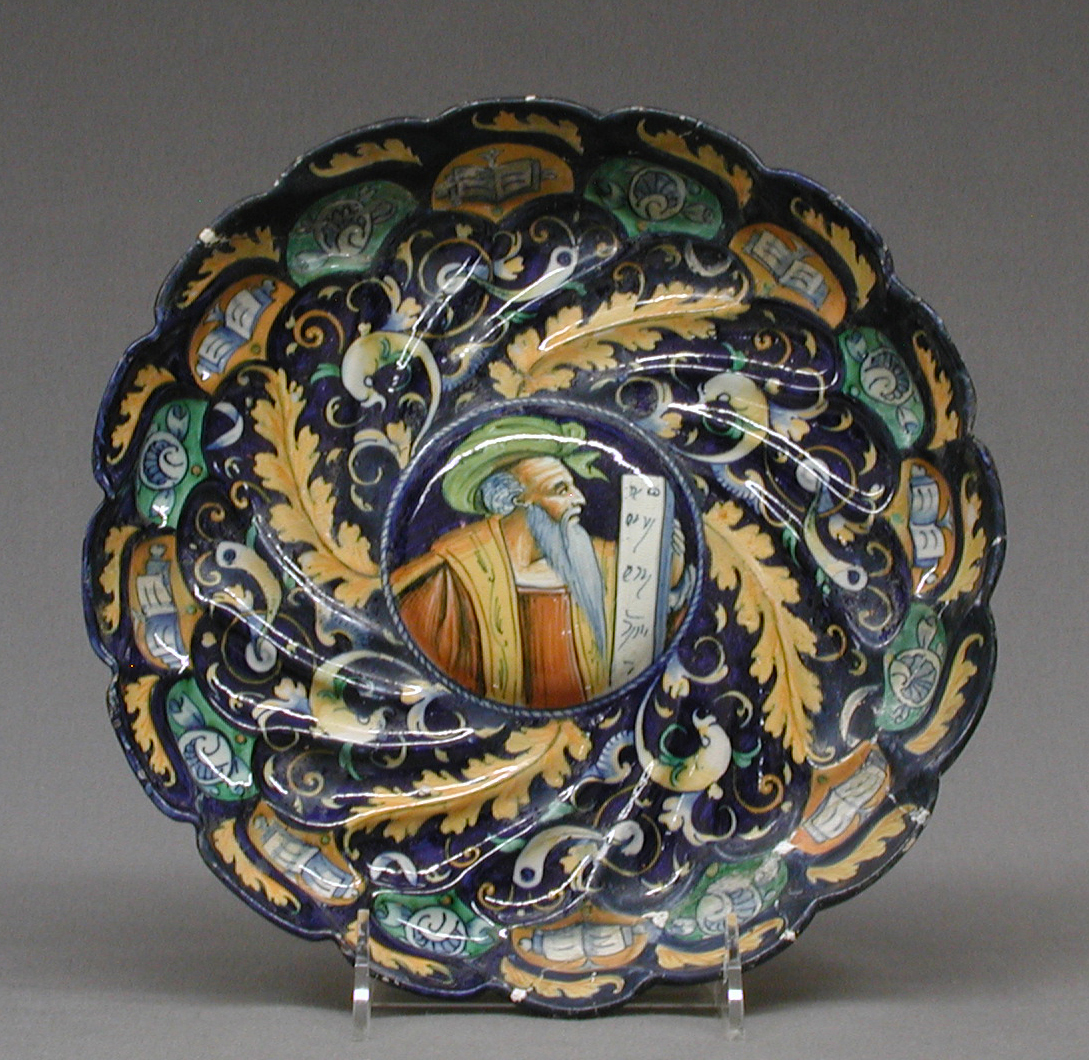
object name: dish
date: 1540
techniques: maiolica, glazing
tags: men,profiles